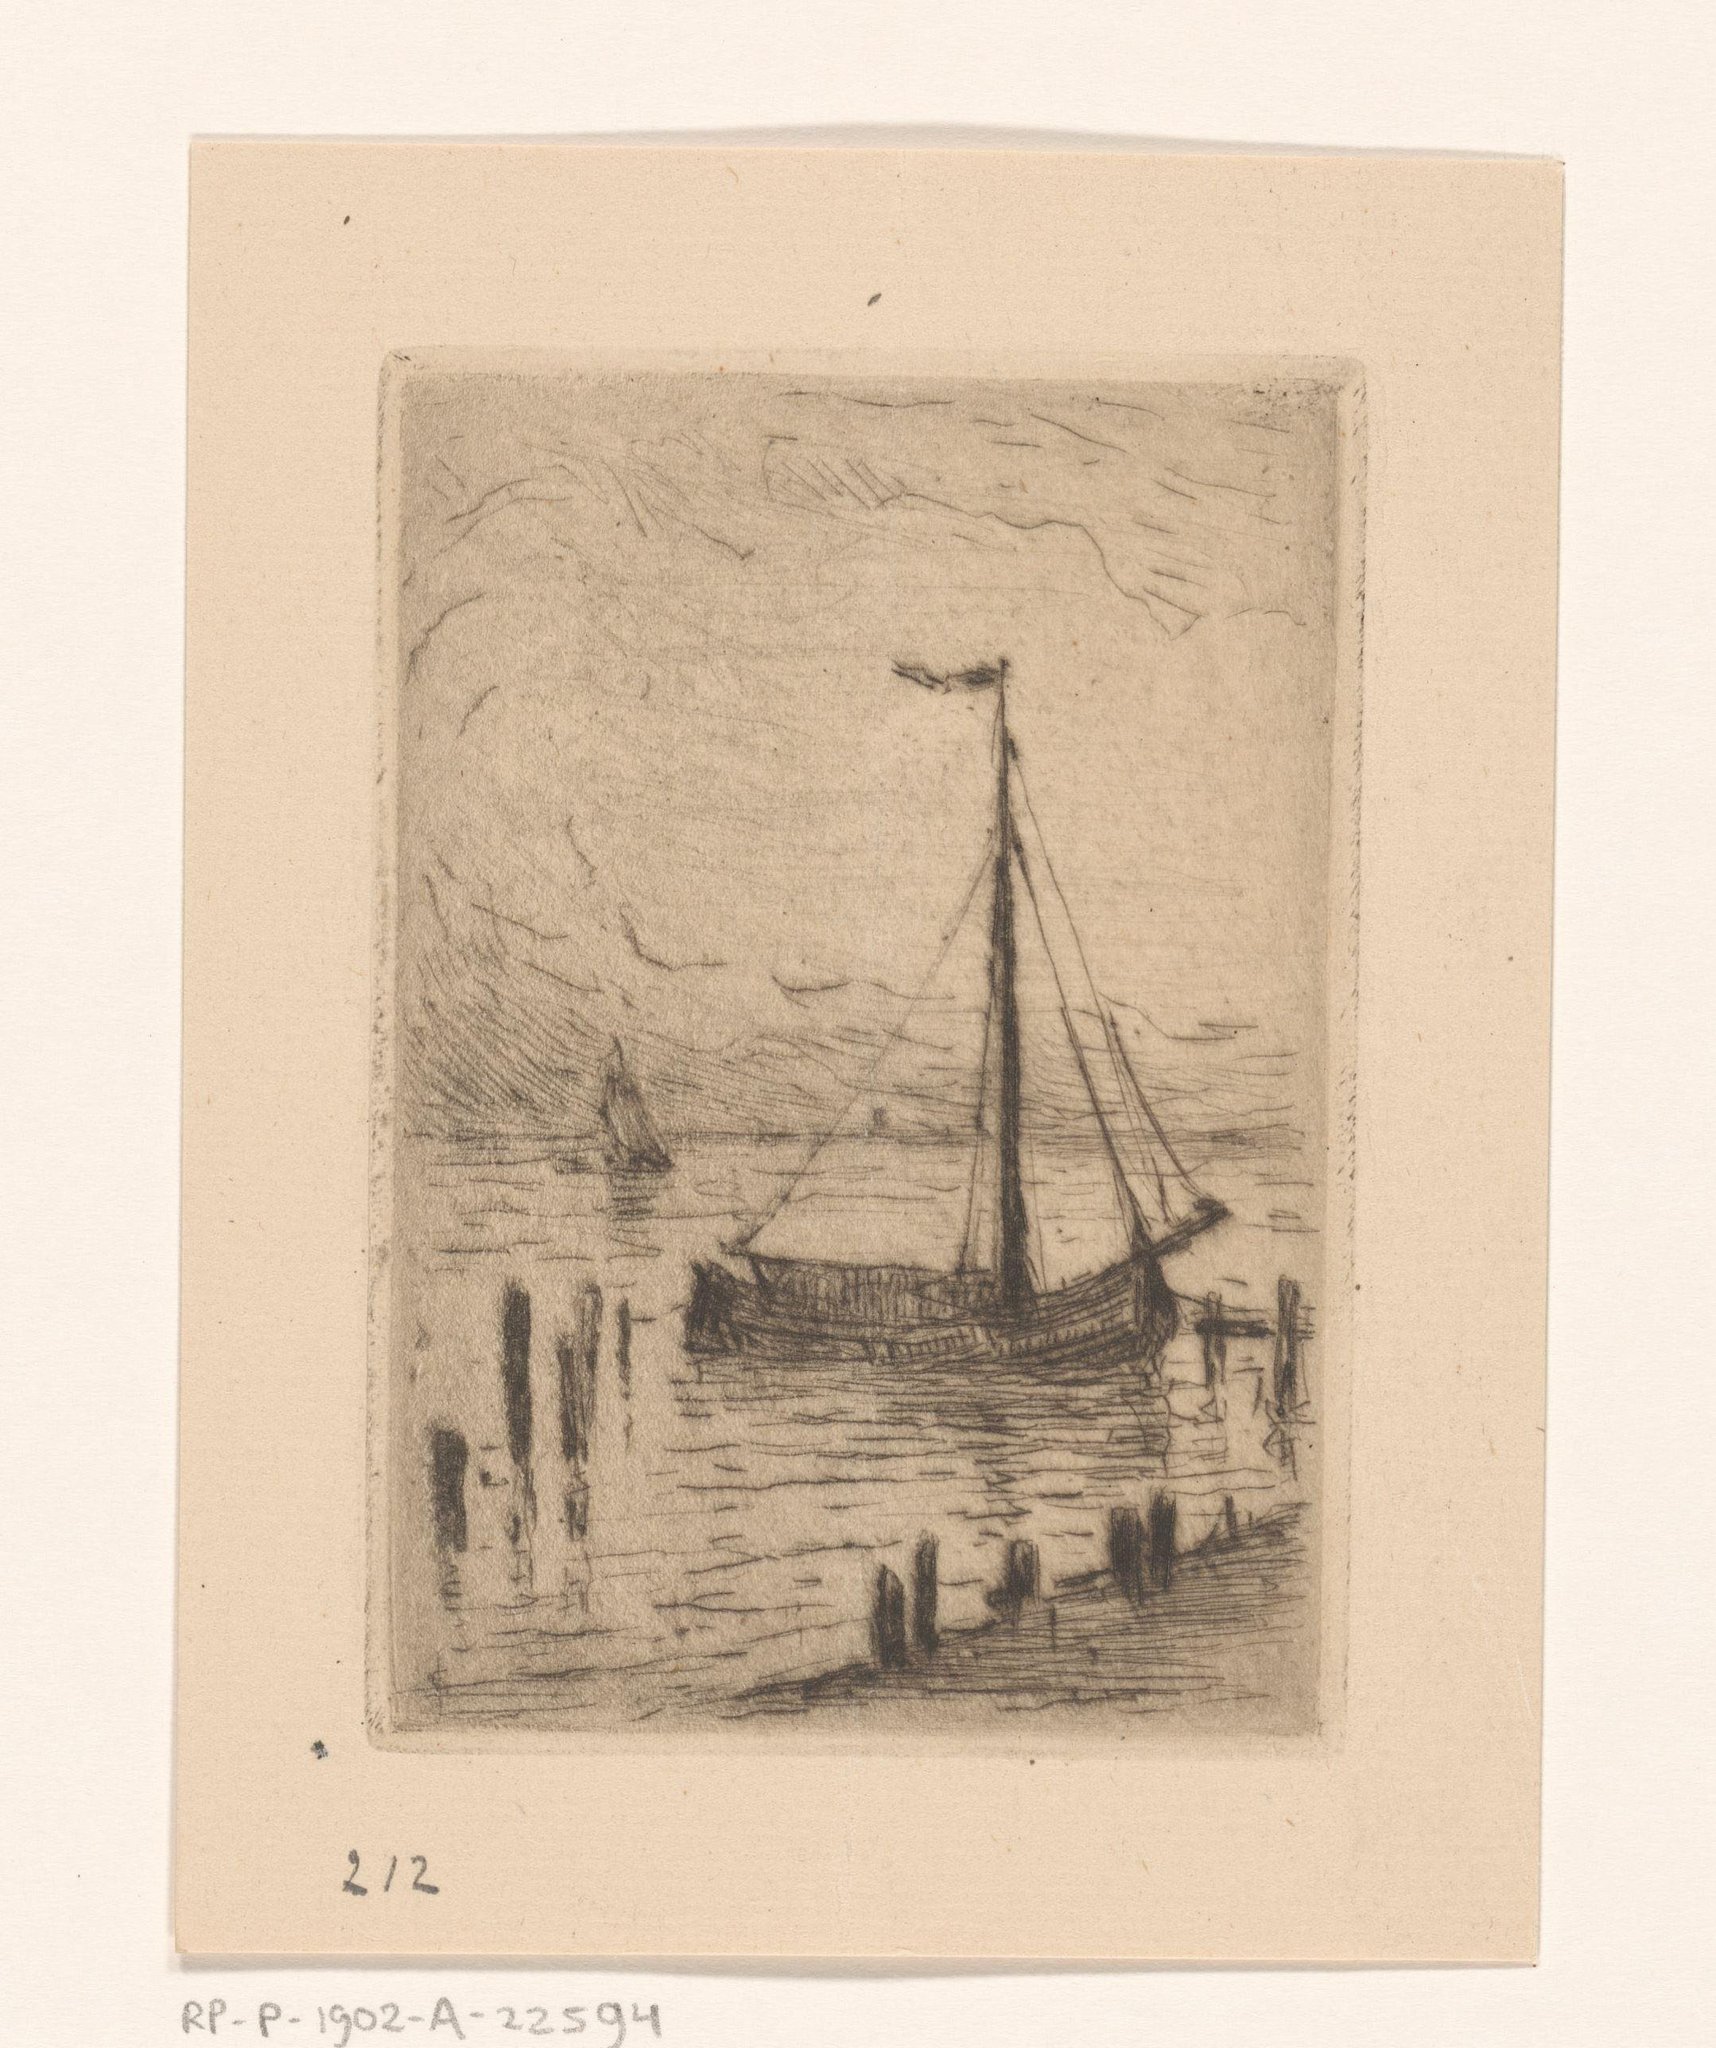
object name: print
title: Afgemeerde zeilboot bij Zeeburg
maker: carel nicolaas storm van s-gravesande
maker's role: draughtsman, print maker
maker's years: 1841-1924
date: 1884-1887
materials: paper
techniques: drypoint, intaglio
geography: netherlands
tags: sailing-ship, sailing-boat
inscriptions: collector's mark: Lugt 2228